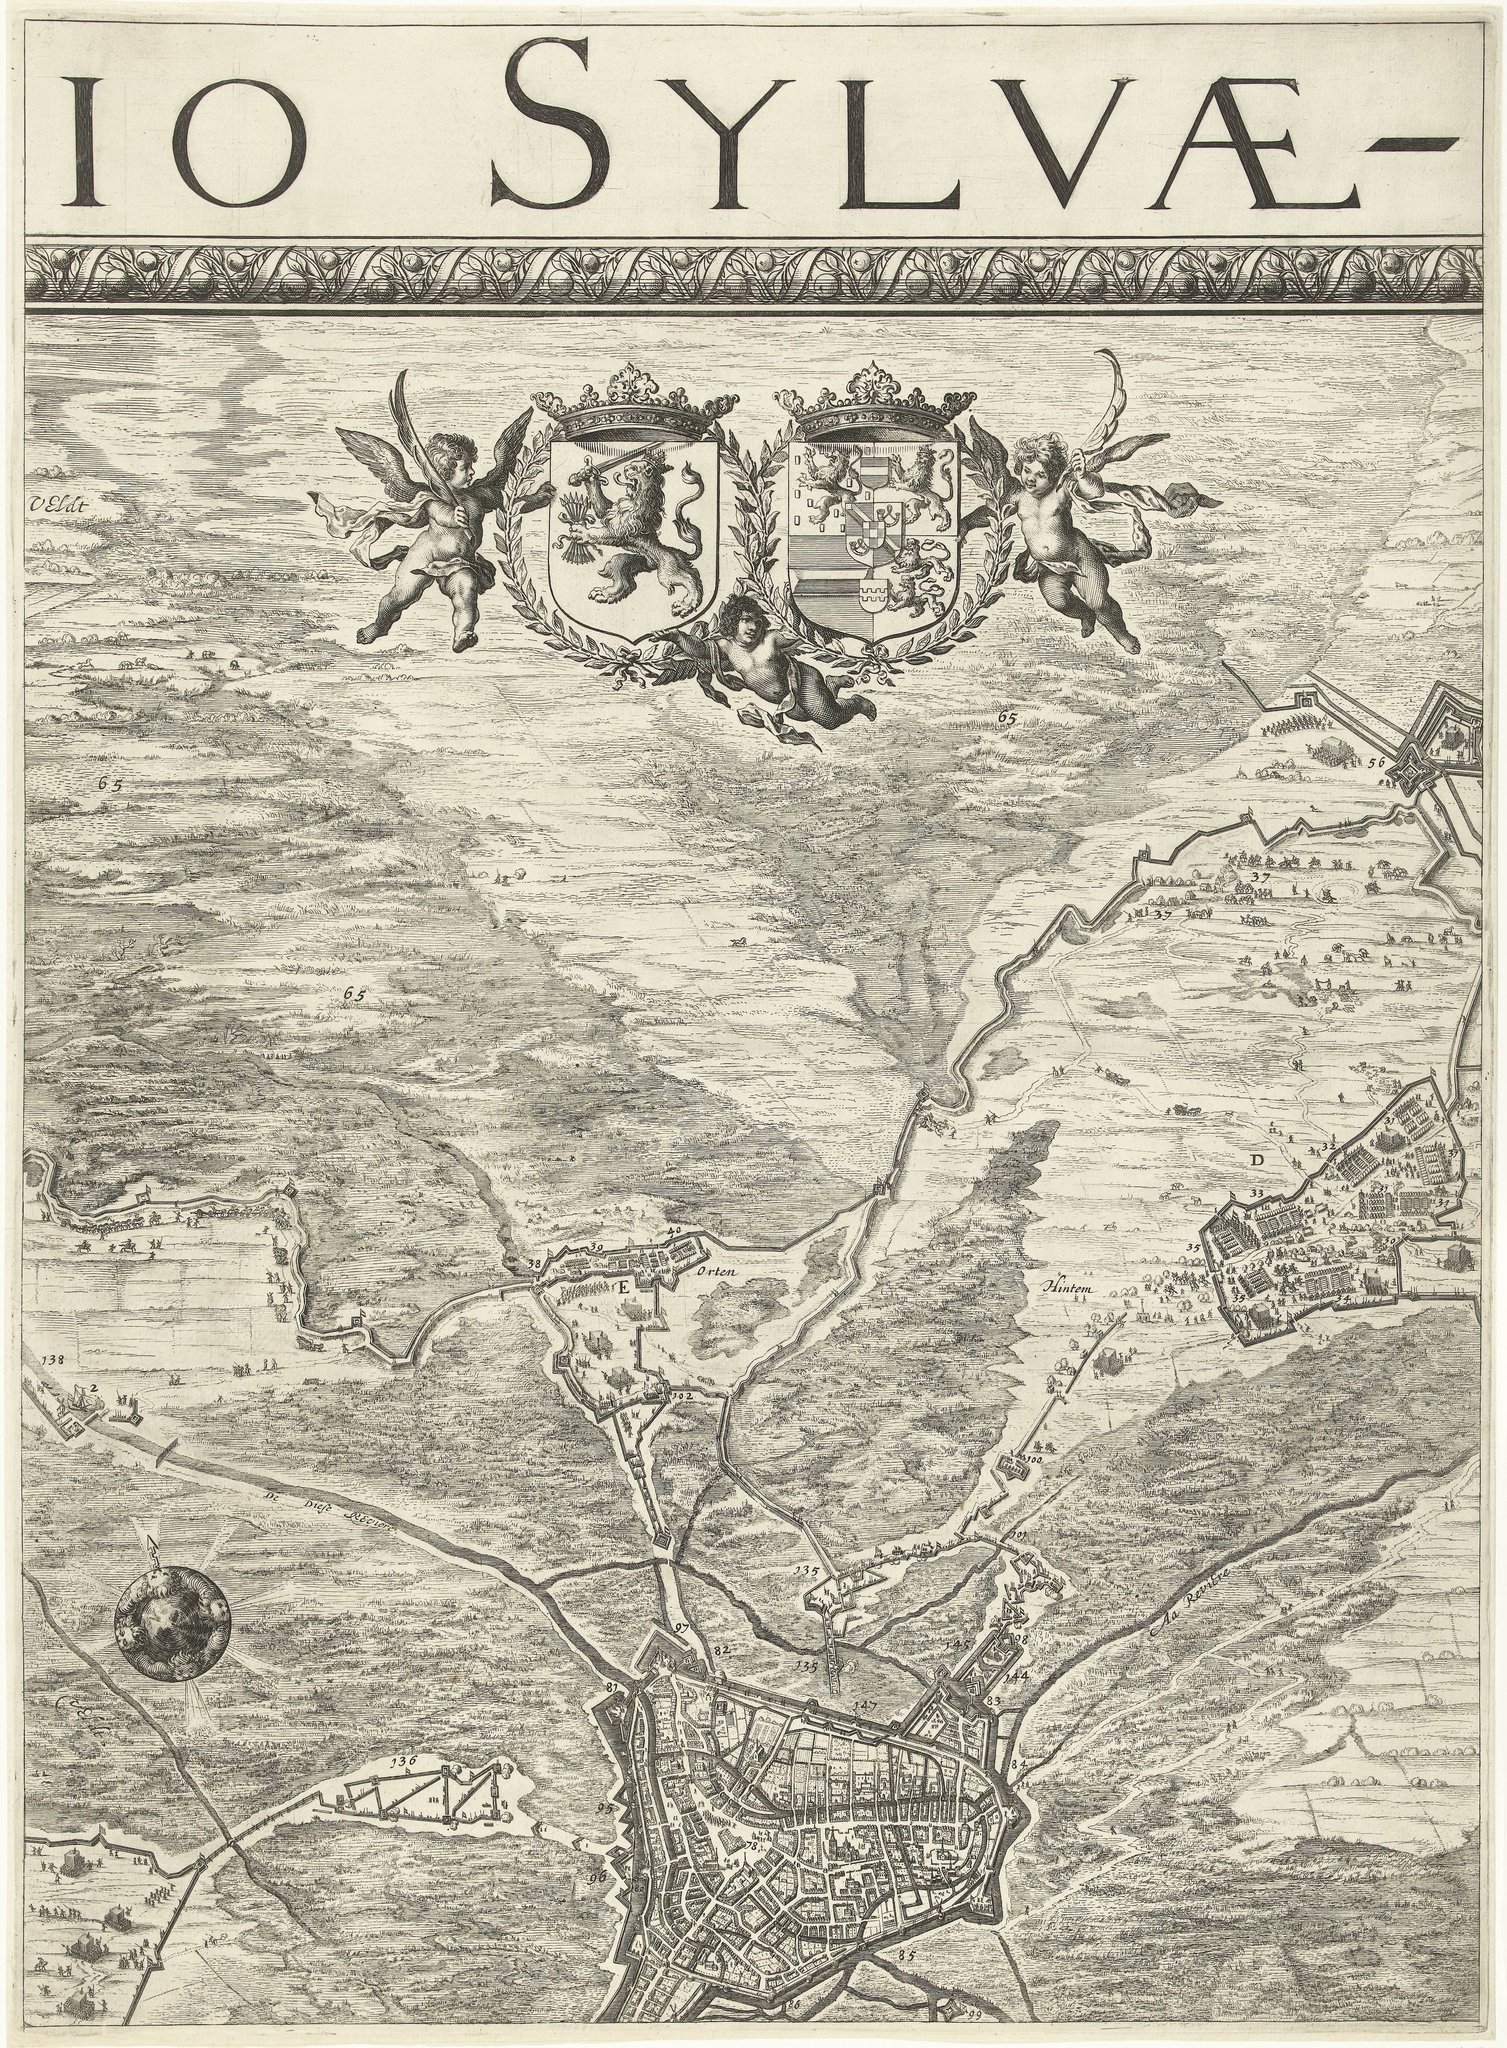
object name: map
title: Expugnatio Sylvae-Ducis Ao 1629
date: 1629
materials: paper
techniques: etching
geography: northern netherlands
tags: frederick henry (prince of orange), maps of separate countries or regions, siege, position war, den bosch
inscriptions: collector's mark: Lugt 2228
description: Grote kaart van het beleg van Den Bosch door het Staatse leger onder Frederik Hendrik, van 1 mei tot 17 september 1629. Aan weerszijden van de kaart 18 kleine voorstellingen met details van de versterkingen van de stad en omliggende forten gemerkt I-Z.. Kaart samengesteld uit zes platen en twee - ontbrekende - tekstbladen. Dit is het blad middenboven met een deel van de kaart met de stad zelf en de wapens van de Staten-Generaal en Frederik Hendrik.